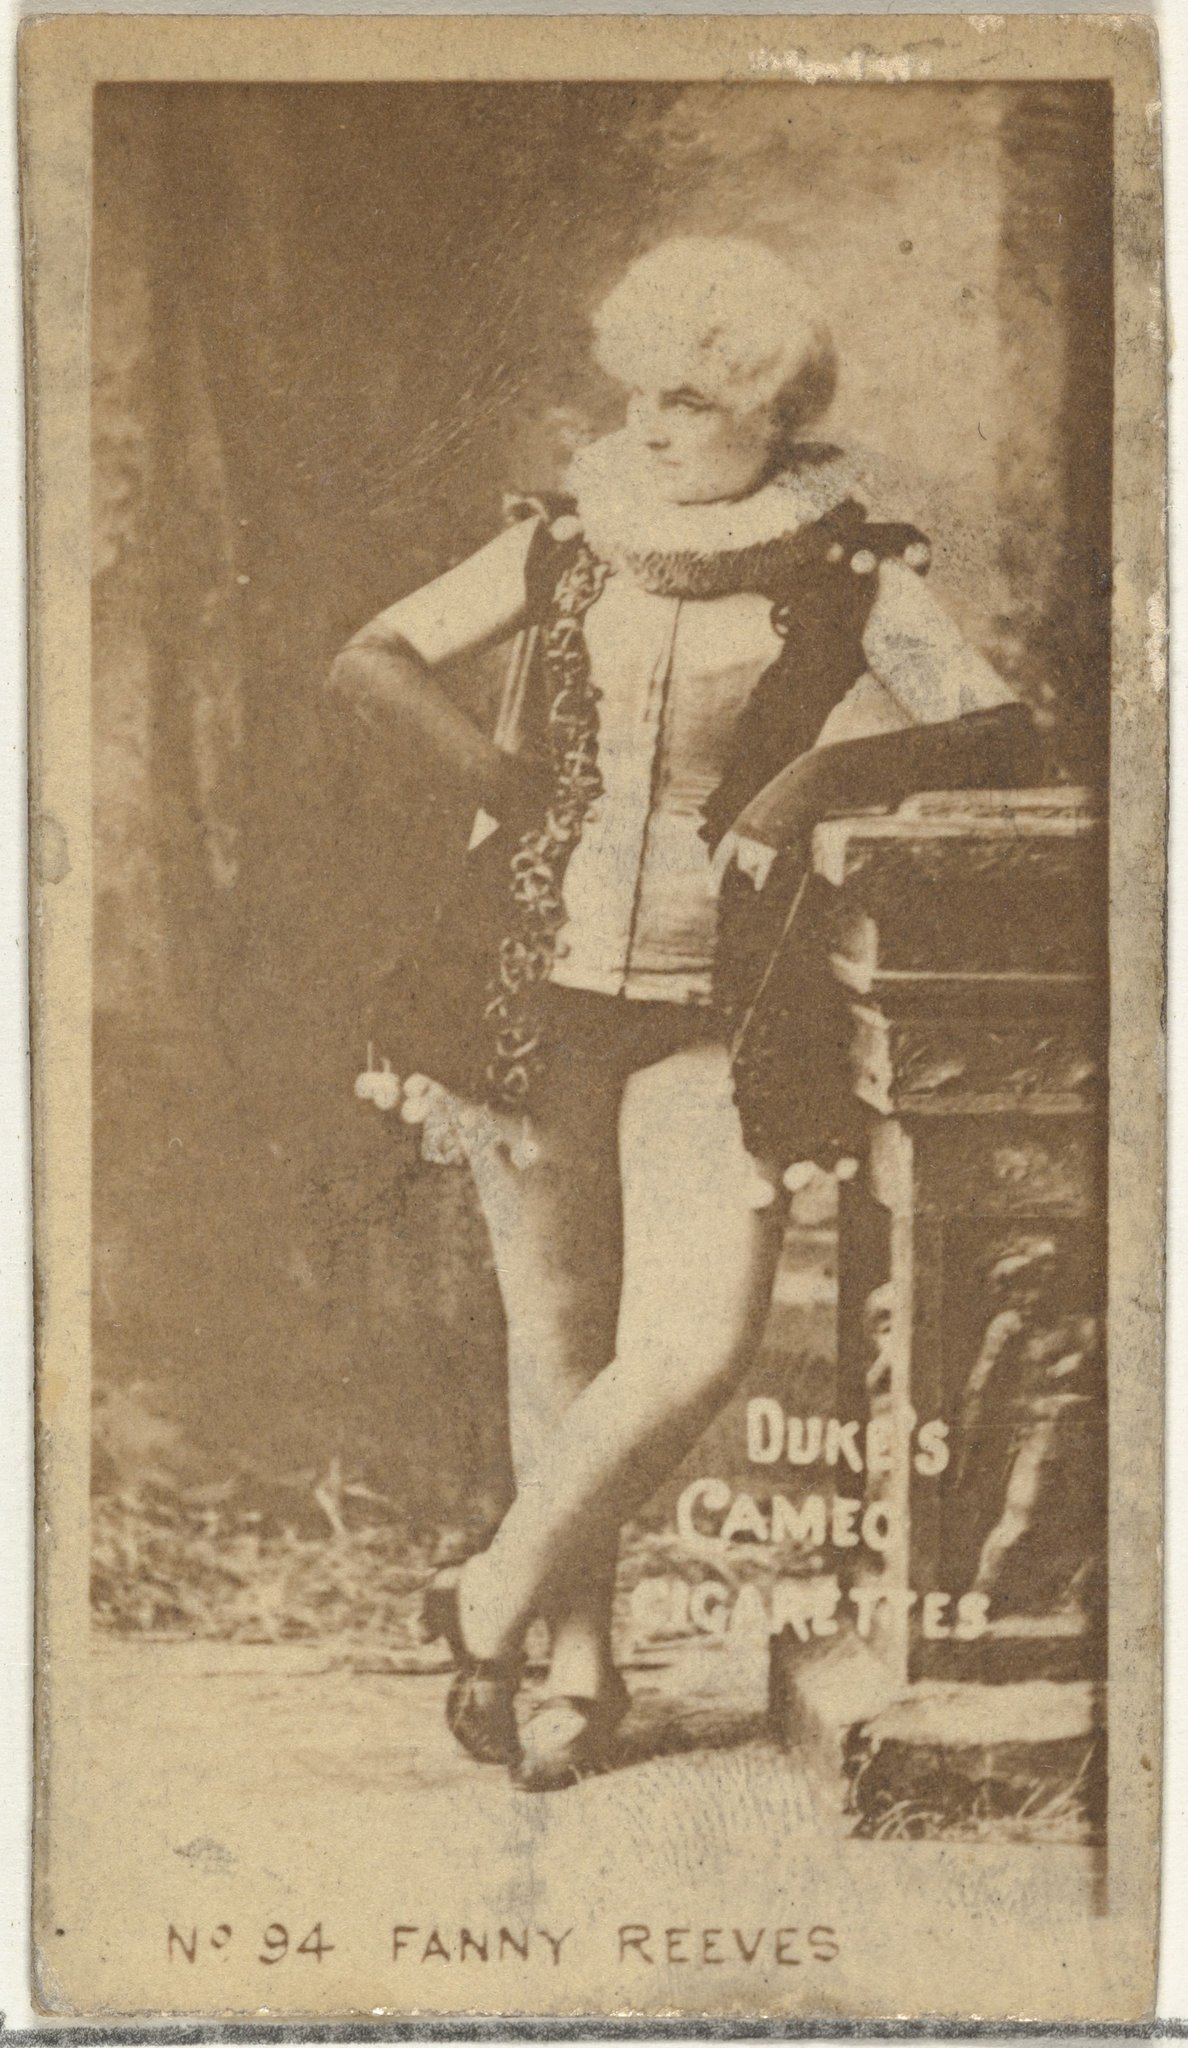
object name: photograph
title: Card Number 94, Fanny Reeves, from the Actors and Actresses series (N145-4) issued by Duke Sons & Co. to promote Cameo Cigarettes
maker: w. duke, sons & co.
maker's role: publisher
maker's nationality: american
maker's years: 1870-1920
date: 1880-1889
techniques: albumen silver print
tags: women,actresses